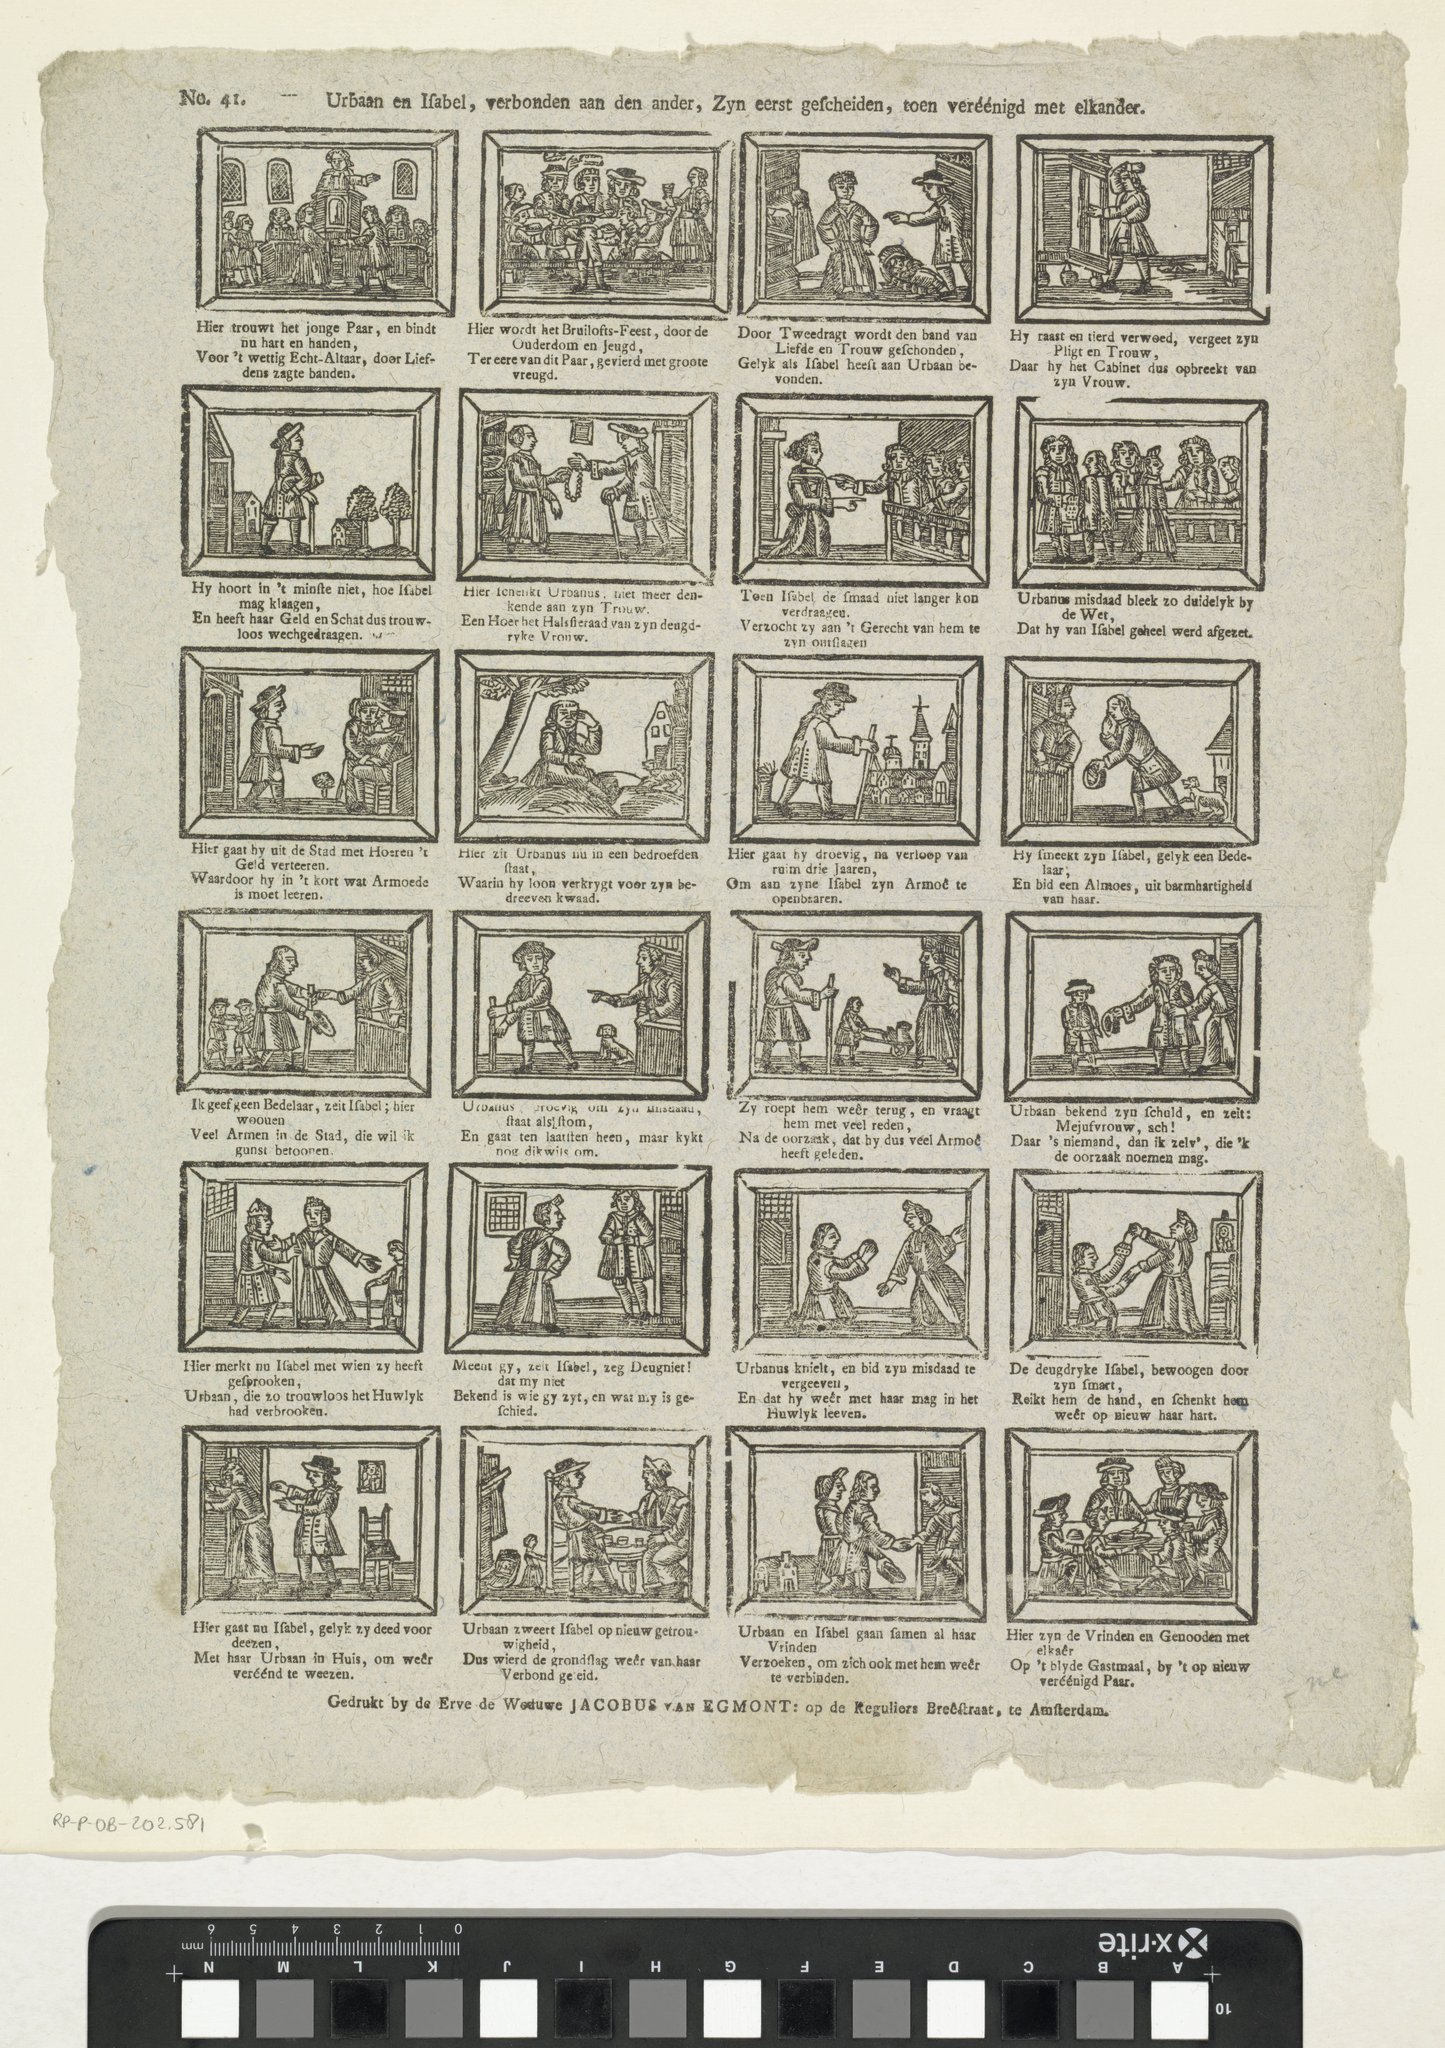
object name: popular print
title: Urbaan en Isabel, verbonden aan den ander, Zyn eerst gescheiden, toen veréénigd met elkander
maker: Anonymous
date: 1761-1804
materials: paper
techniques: letterpress printing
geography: amsterdam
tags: bad husband, tales and fairy tales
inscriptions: collector's mark: Lugt 2760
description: Blad met 36 voorstellingen van het verhaal van Urbaan (Urbanus) en Isabel. Ze trouwen, maken ruzie, gaan scheiden, en Urbanus wordt een bedelaar. Onder elke afbeelding een vers. Genummerd linksboven: No. 41.